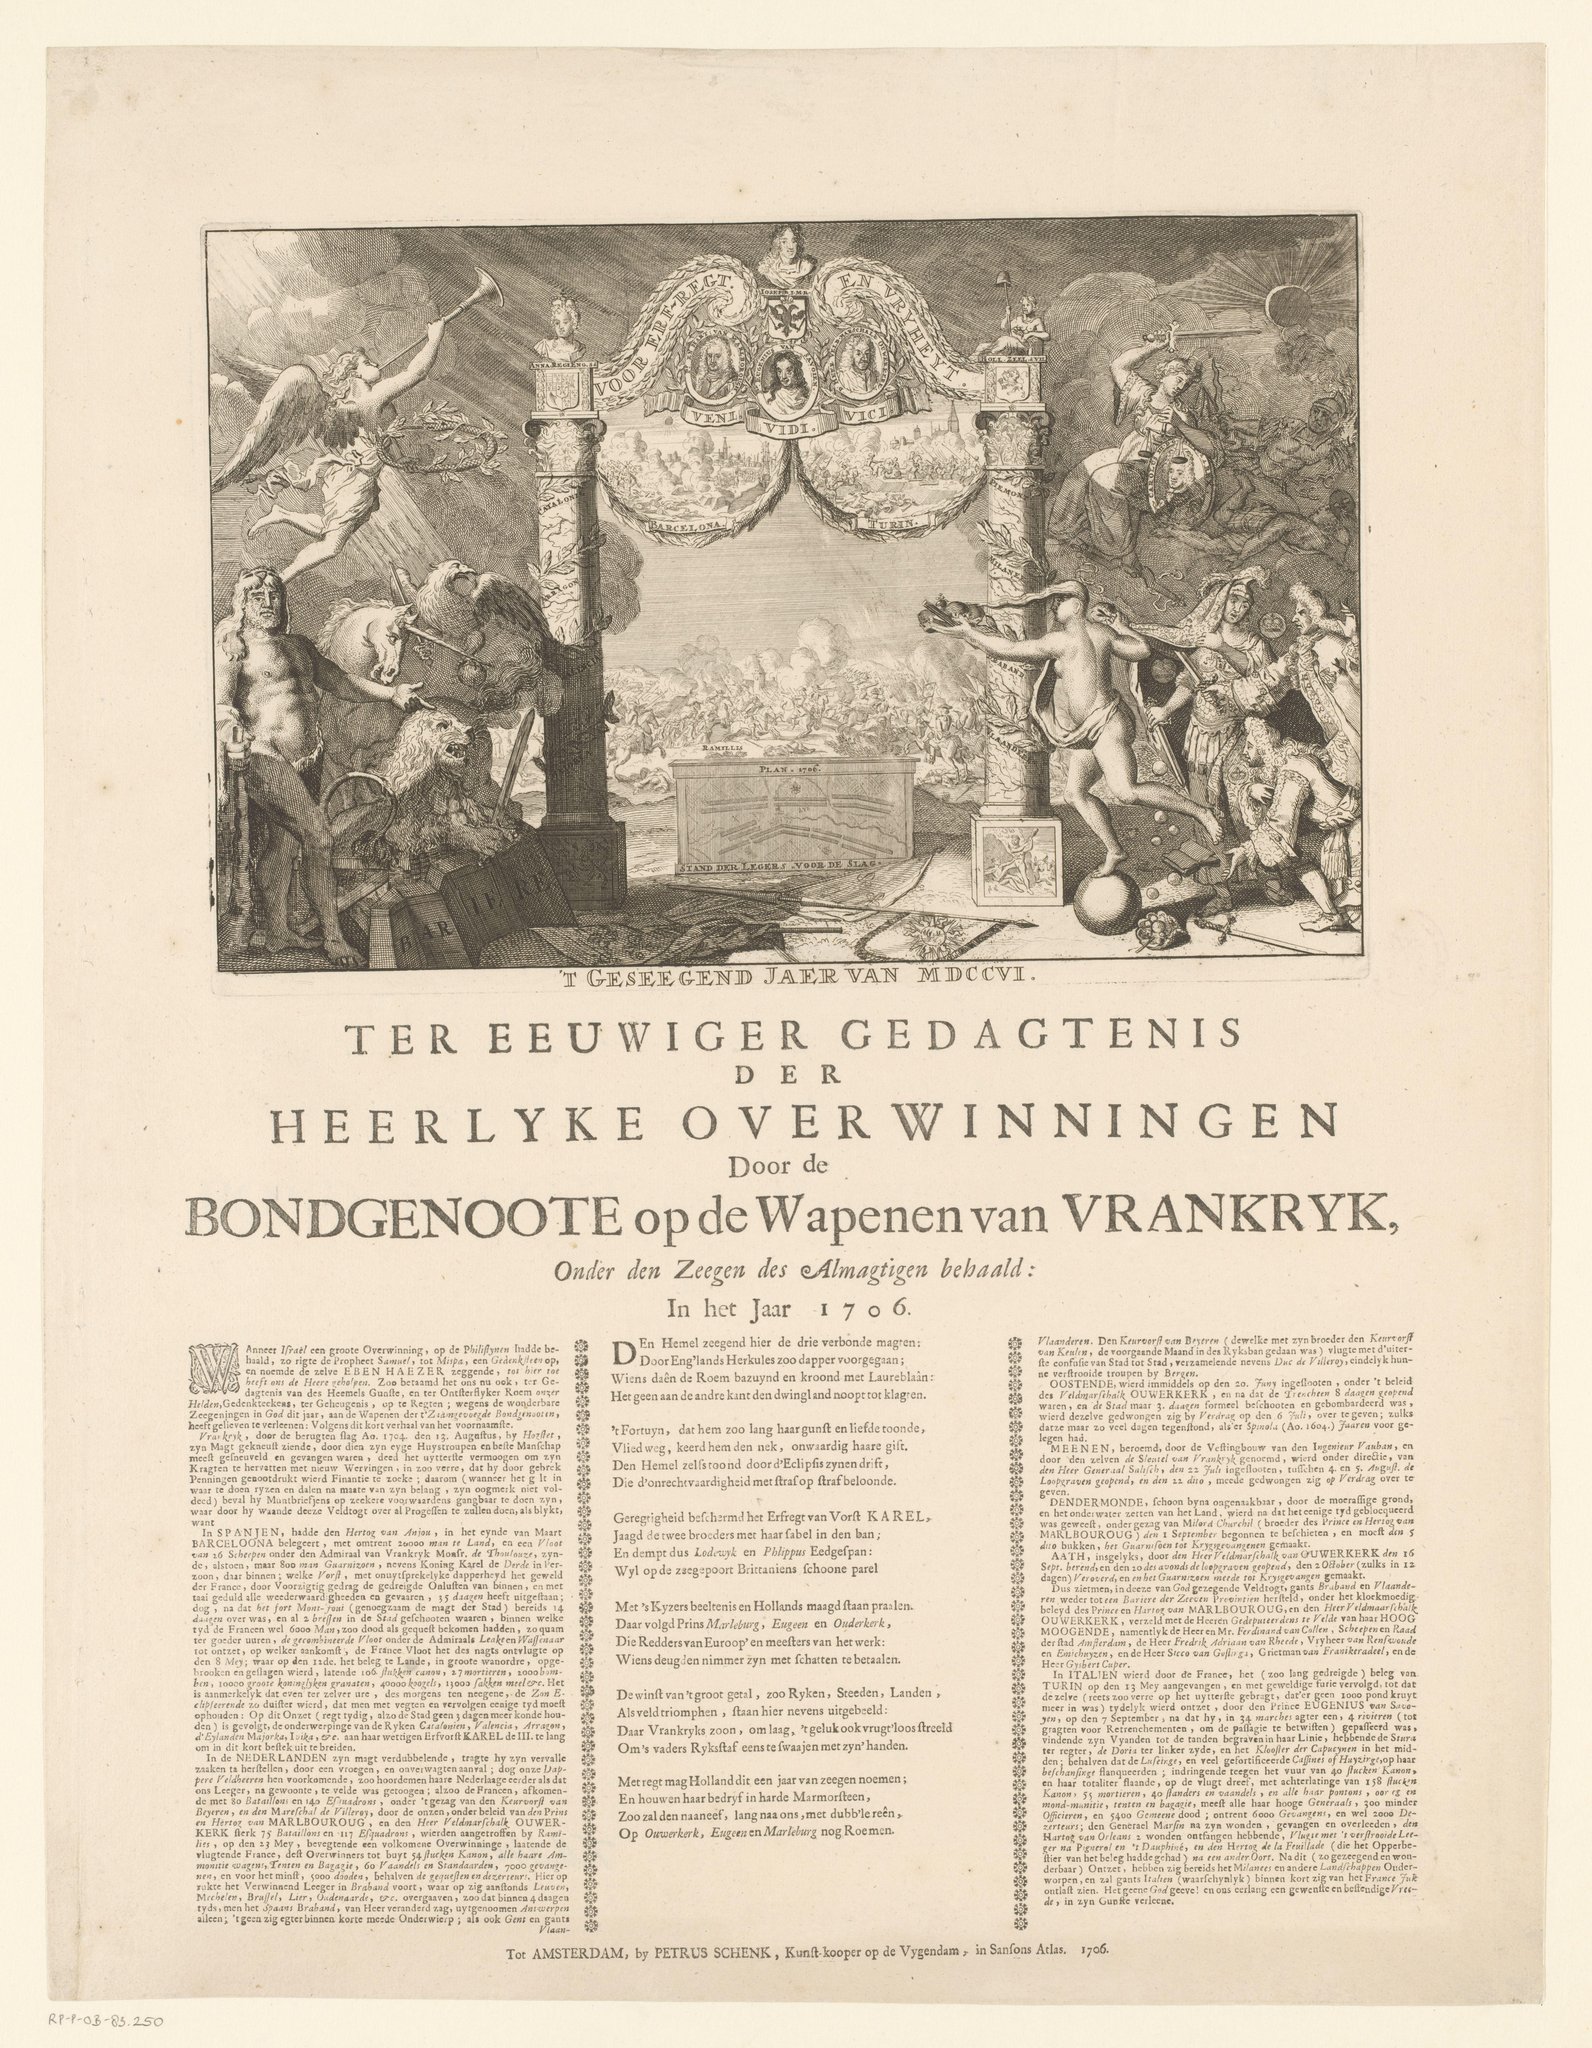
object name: print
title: Ter Eeuwiger Gedagtenis der Heerlyke Overwinningen Door de Bondgenoote op de Wapenen van Vrankryk, Onder den Zeegen des Almagtigen behaald: In het Jaar 1706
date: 1706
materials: paper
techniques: engraving, etching, letterpress printing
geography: northern netherlands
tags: paris, eugenius van savoye, john churchill (1e hertog van marlborough), vienna, charles vi (holy roman emperor), luck, fortune, lot; 'fato', 'fortuna', 'fortuna aurea', 'fortuna buona', 'fortuna pacifica overo clemente', 'sorte' (ripa), battle (+ land forces)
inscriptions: collector's mark: Lugt 240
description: Allegorie op de overwinningen behaald door de Geallieerden op de Fransen in het jaar 1706. Ereboog met portretten van de hertog van Marlborough, prins Eugenius van Savoye en de Heer van Ouwerkerk. Met kleine voorstellingen van de slag bij Ramillies, het ontzet van Turijn en Barcelona. Links Hercules met de Nederlandse Leeuw, de Engelse eenhoorn en de Duitse adelaar. Rechts Fortuna met de vorsten van Frankrijk, Keulen en Beieren. Rechts verdedigt in de lucht Rechtvaardigheid de zaak van Karel III. Op het blad gedrukt onder de plaat een tekst in 3 kolommen.